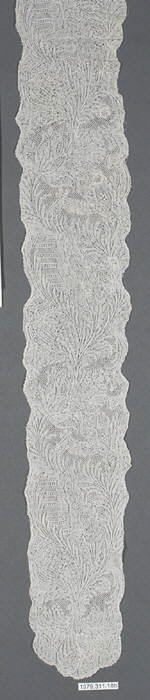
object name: lappet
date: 1701-1800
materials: linen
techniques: lace